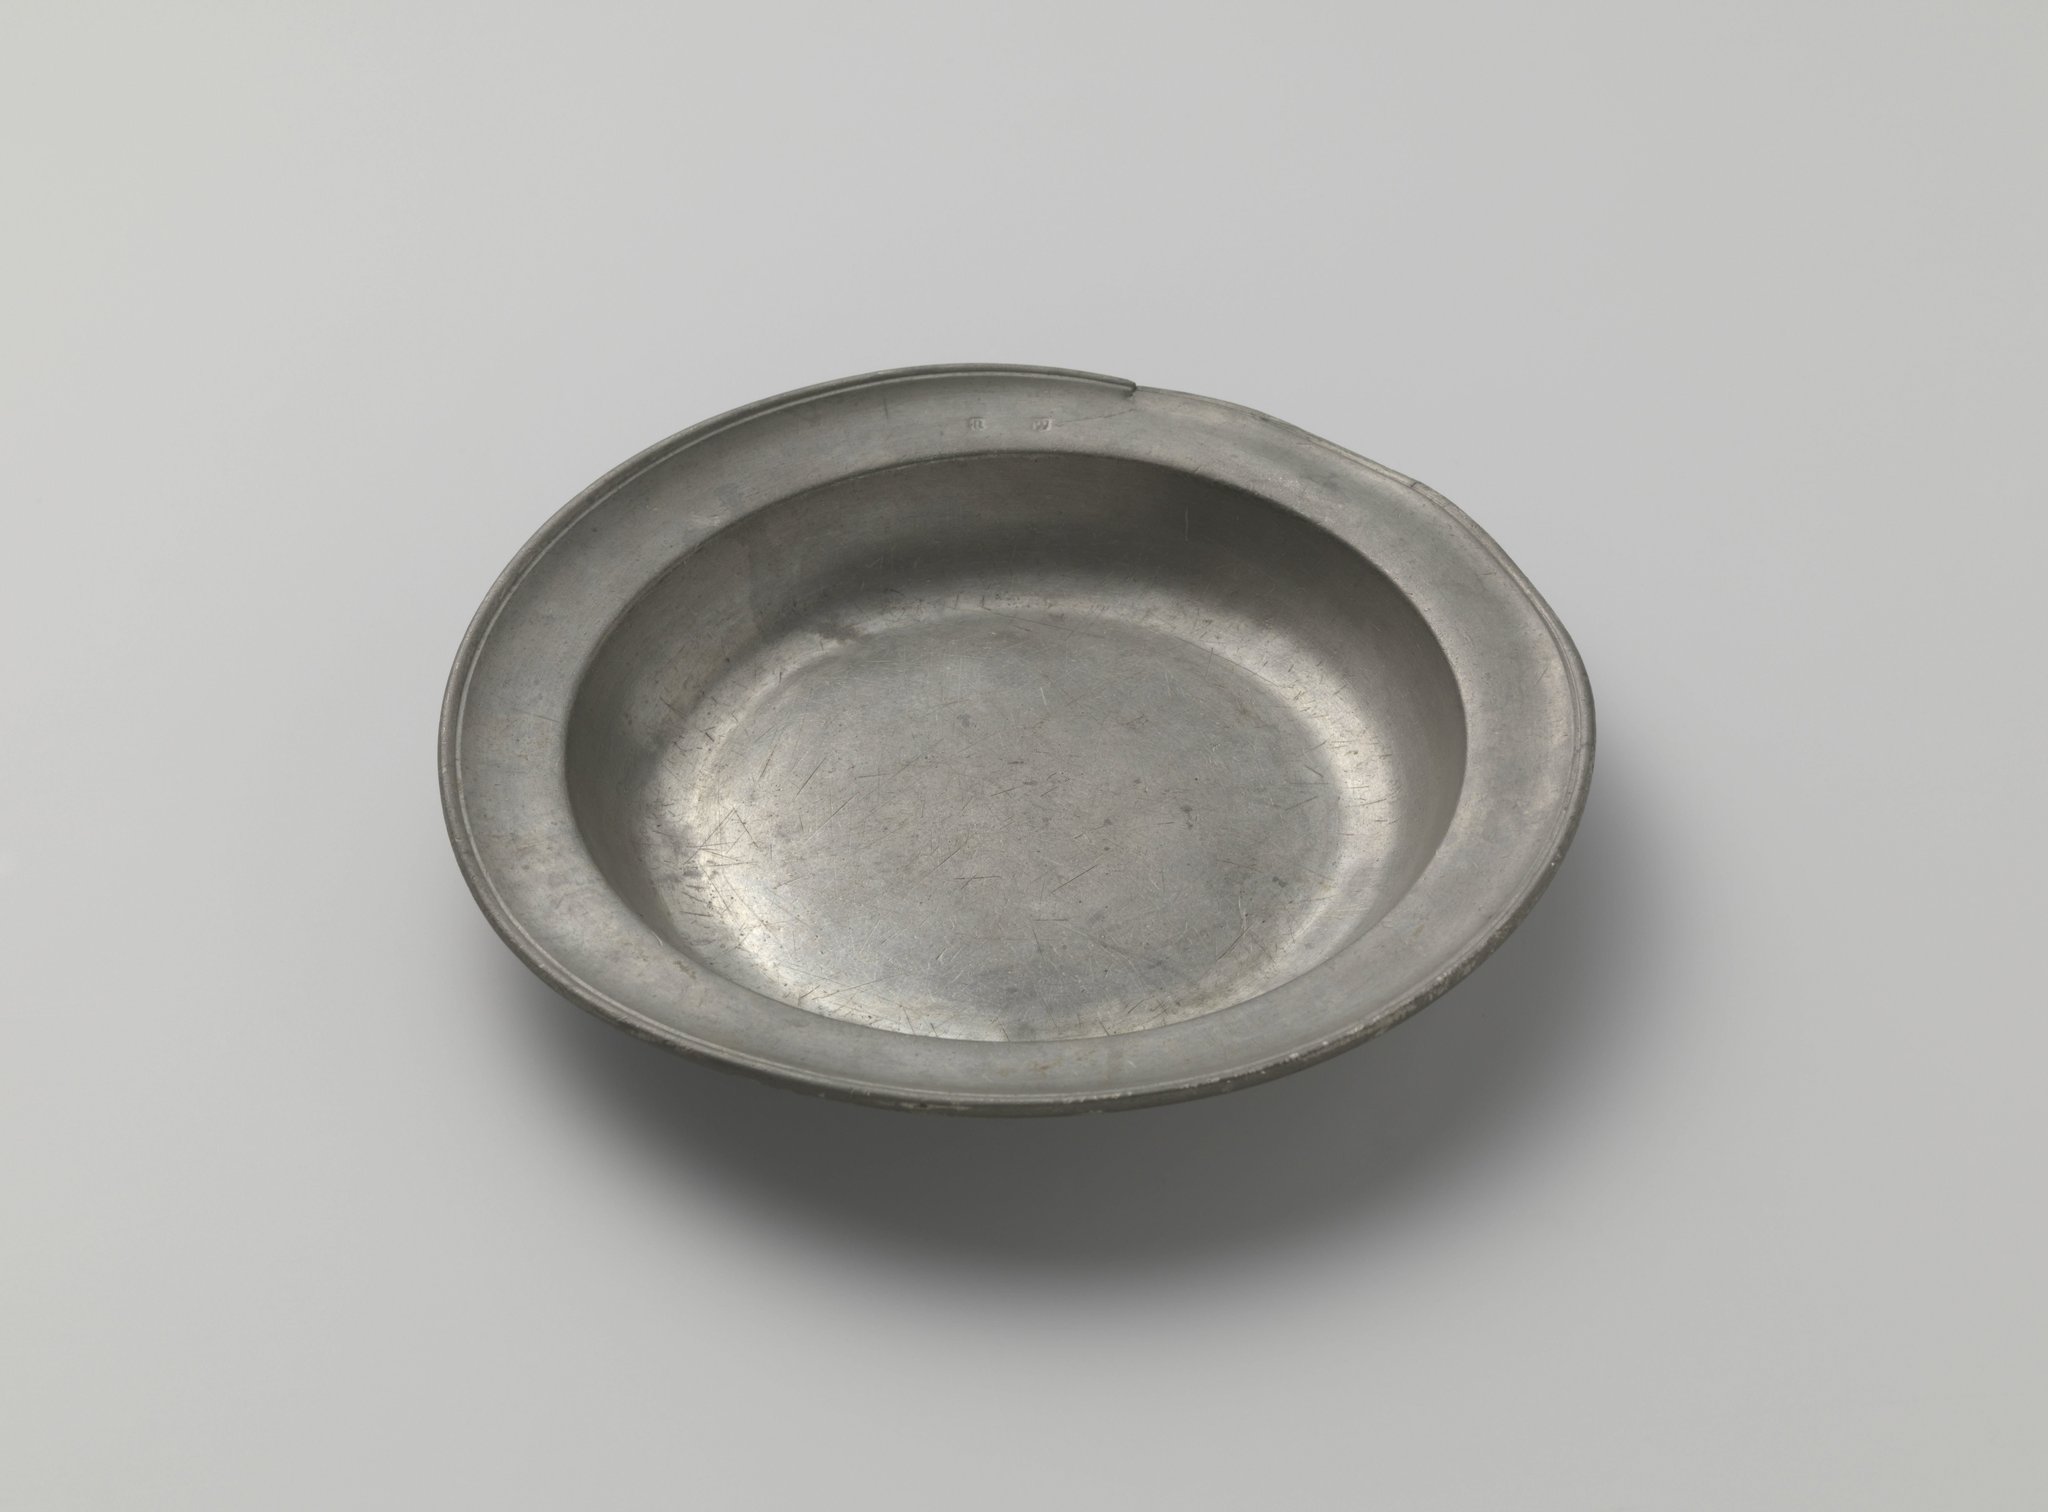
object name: plate dish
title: Rond bord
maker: carolus theodorus de ruijr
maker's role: pewterers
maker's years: 1749-1795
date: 1770-1795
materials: tin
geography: roermond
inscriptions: inscription: ‘RW’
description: Rond bord van tin. De dunne rand is omgeslagen.